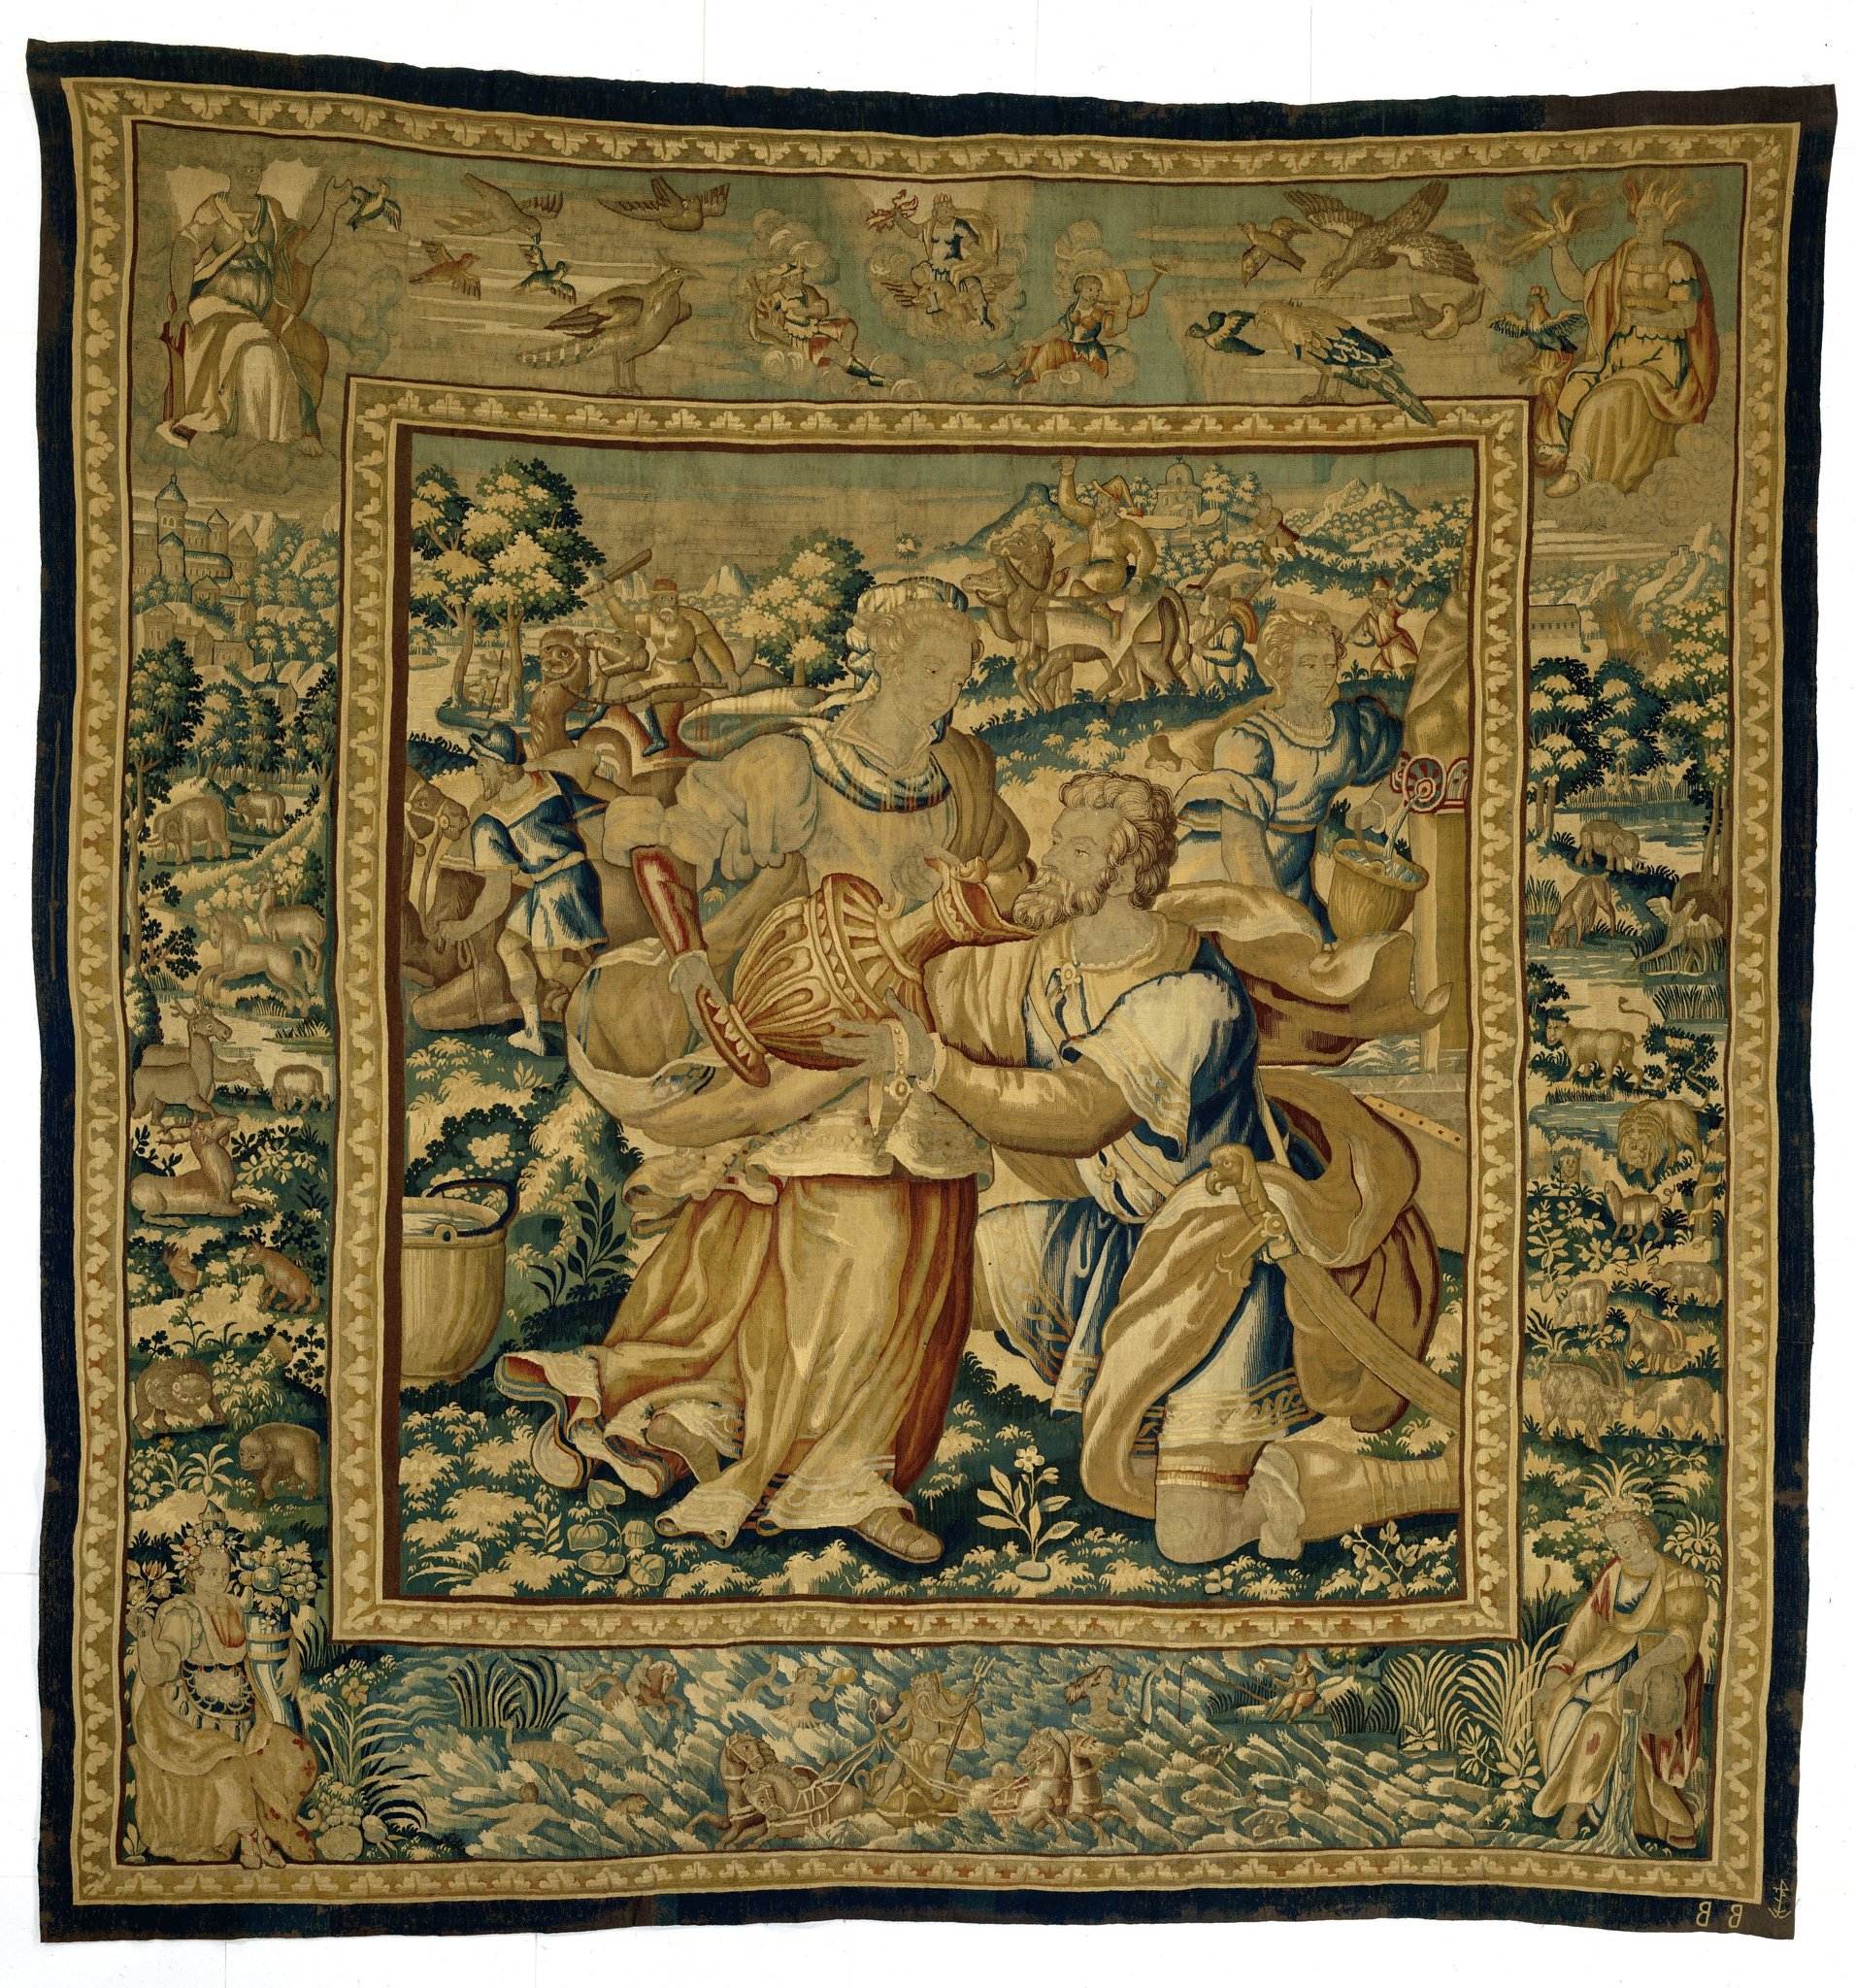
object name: tapestry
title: Rebekka en Eliëzer bij de bron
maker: Anonymous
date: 1575-1600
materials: silk, wool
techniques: tapestry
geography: brussels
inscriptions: weaver's mark, town mark: ‘BB’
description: Wandtapijt met Rebecca die Eliezer te drinken geeft (Gen. 24:18), uit een serie wandtapijten met de geschiedenis van Rebecca en Eliezer (Gen.24) met randen met dieren en in de hoeken de vier elementen; met het weversmerk van Willem de Kempeneere.